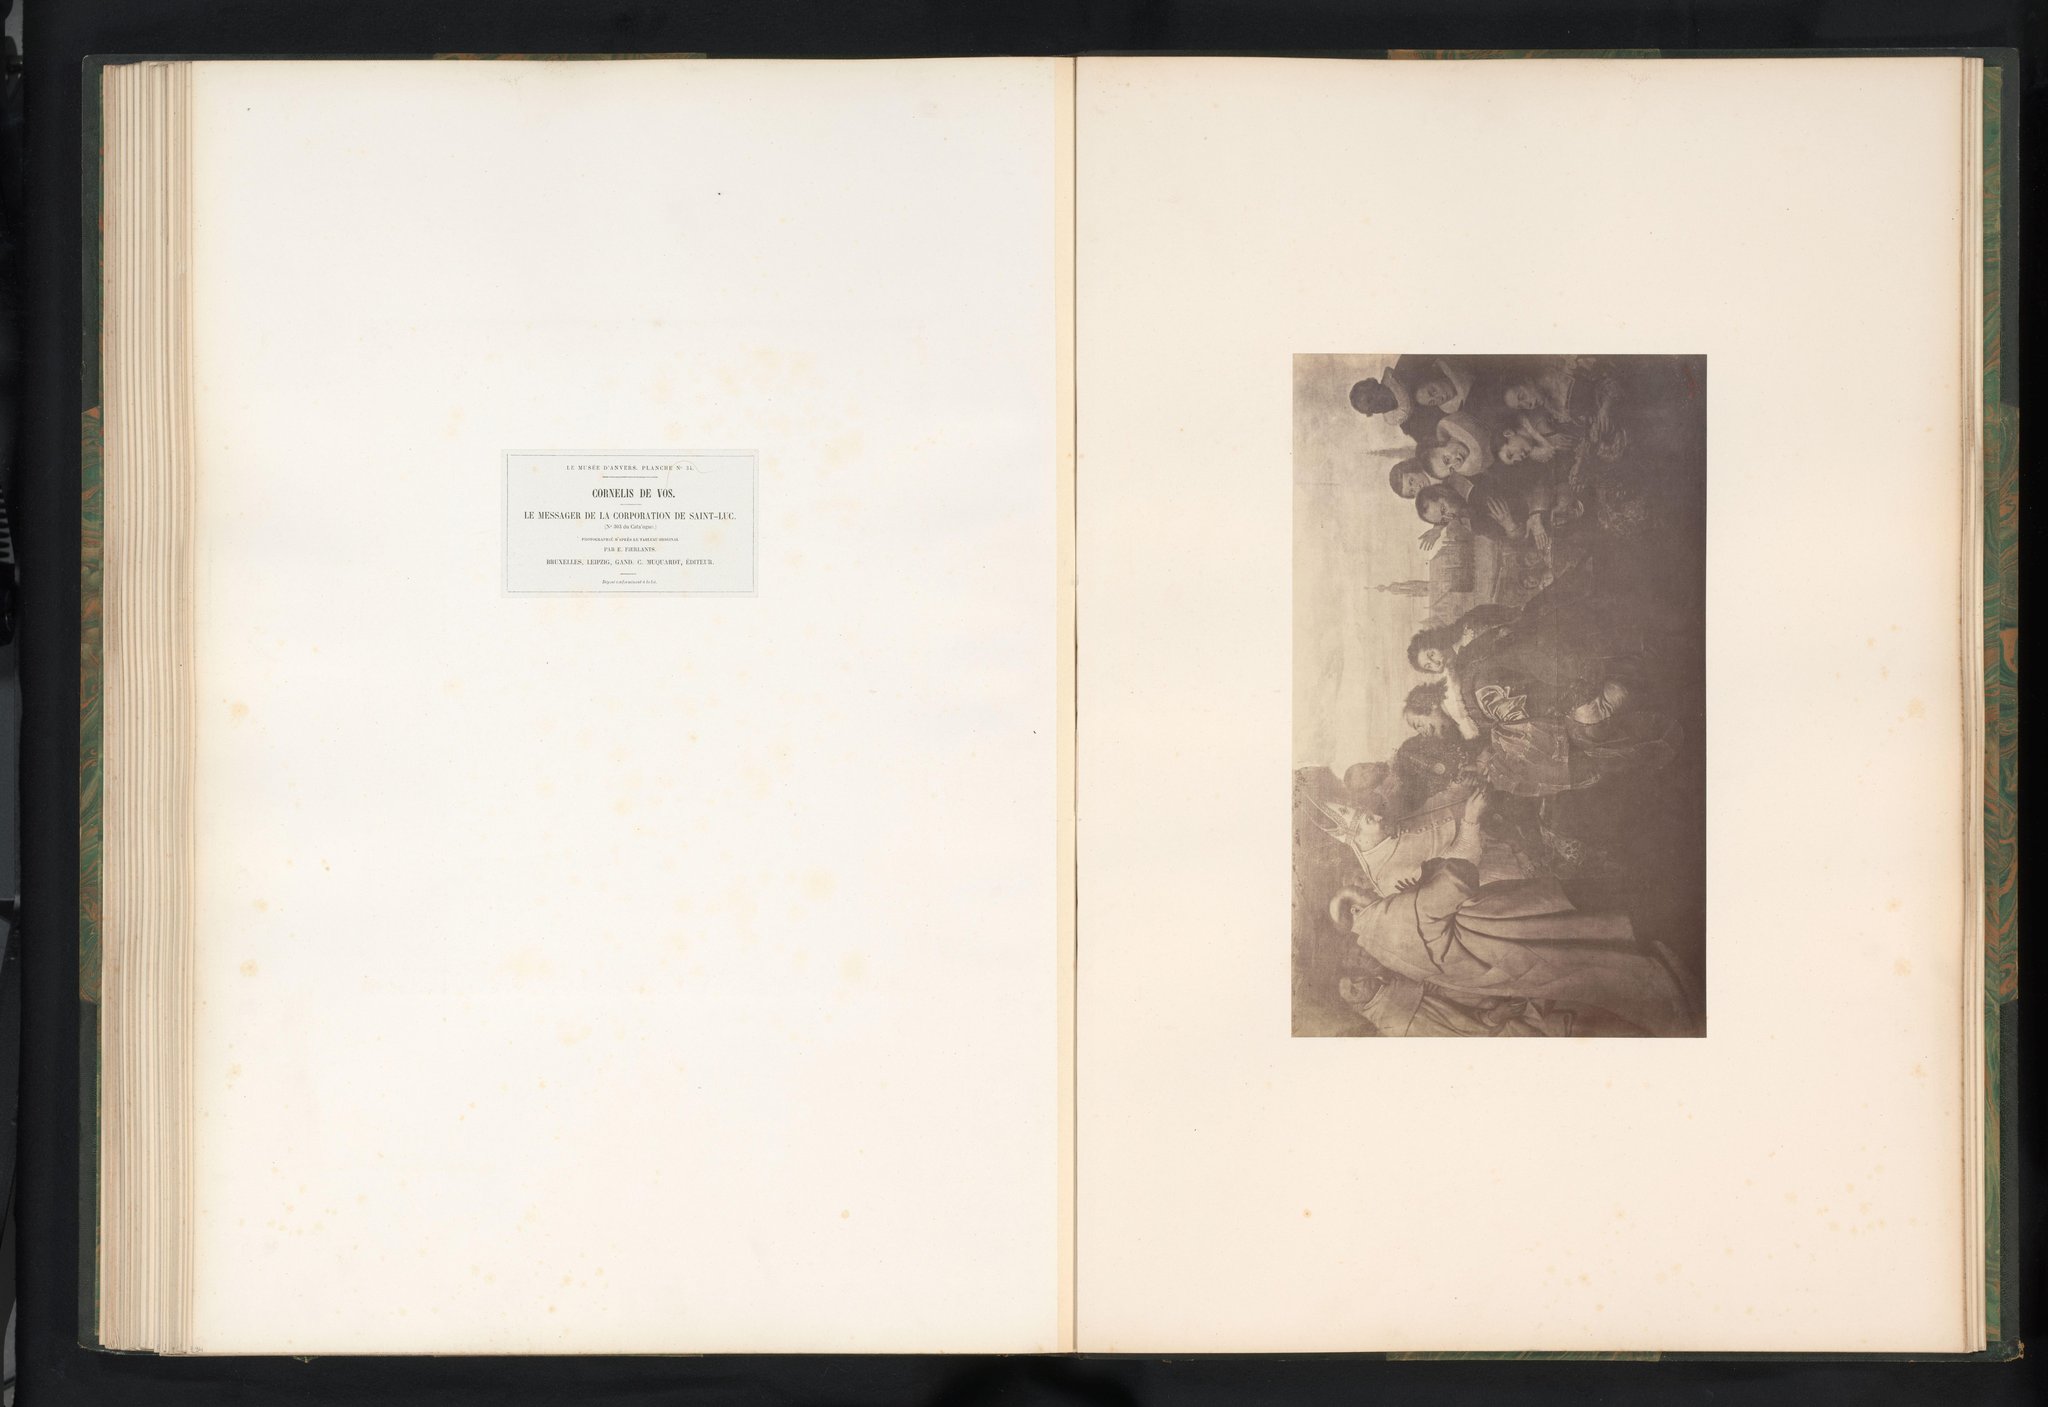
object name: page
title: Fotoreproductie van De burgers van Antwerpen brengen de monstrans en de gewijde vaten die ze verstopt hadden voor Tanchelm naar de heilige Norbertus van Magdeburg door Cornelis de Vos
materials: photographic support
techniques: albumen print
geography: brussels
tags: the citizens of antwerp bring back to st. norbert the monstrance and other sacred vessels that they had hidden from tankelin